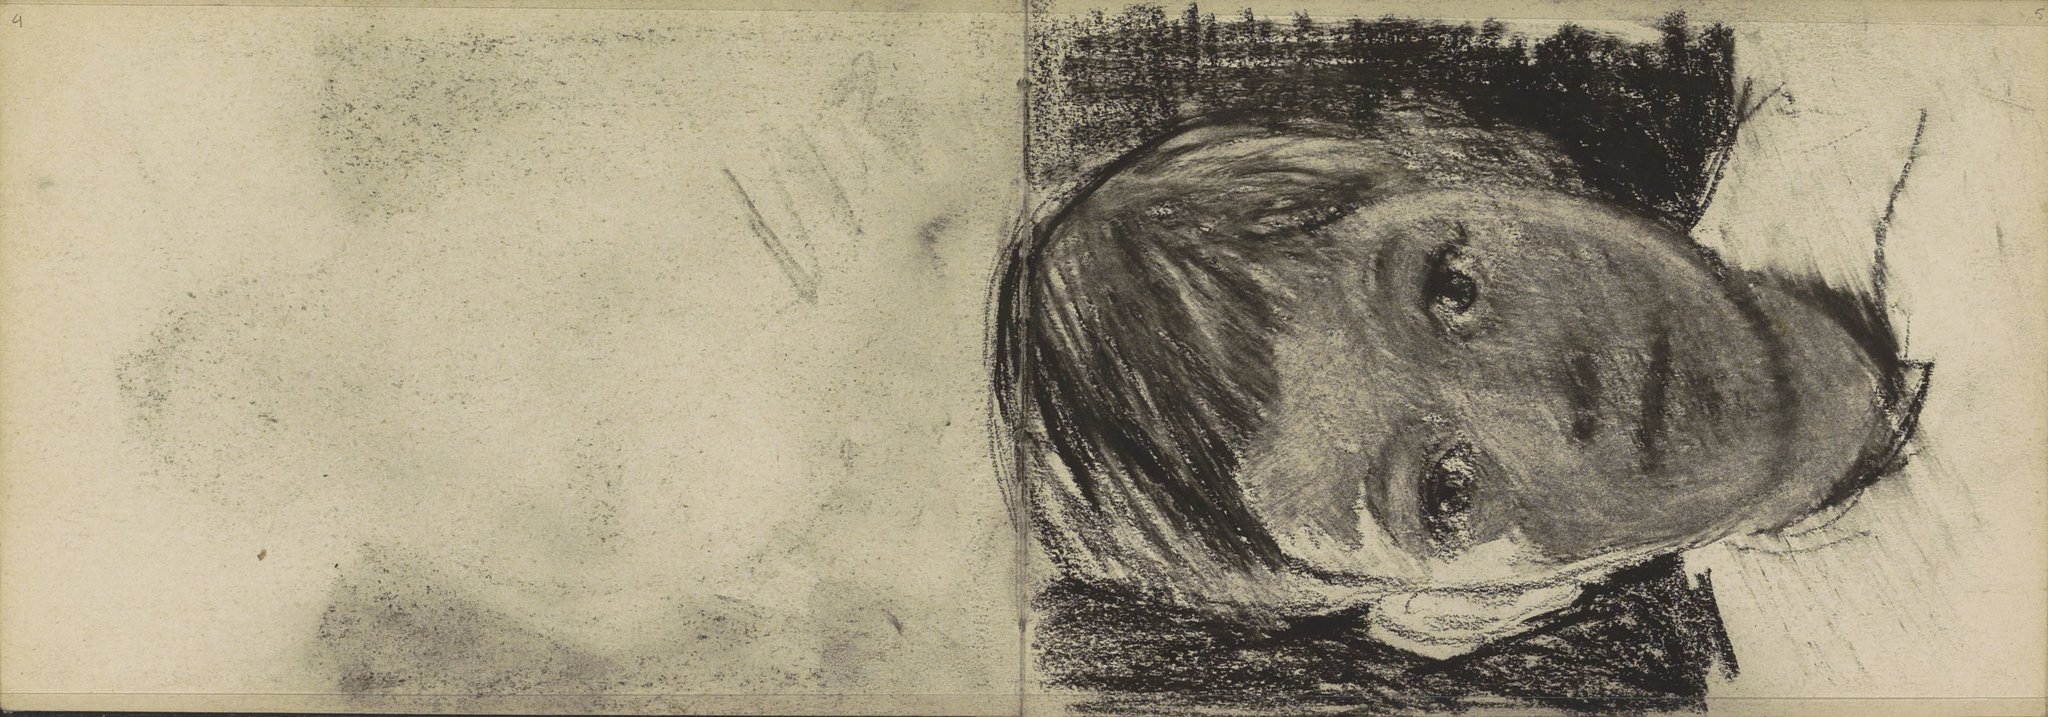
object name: sketchbook leaf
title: Buste van een jongen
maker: willem witsen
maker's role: draughtsman, painter, print maker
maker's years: 1860-1923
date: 1906-1907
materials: chalk, paper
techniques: stumping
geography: wijk bij duurstede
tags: boy (child between toddler and youth)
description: Pagina 4 en pagina 5 uit een schetsboek met 25 bladen.